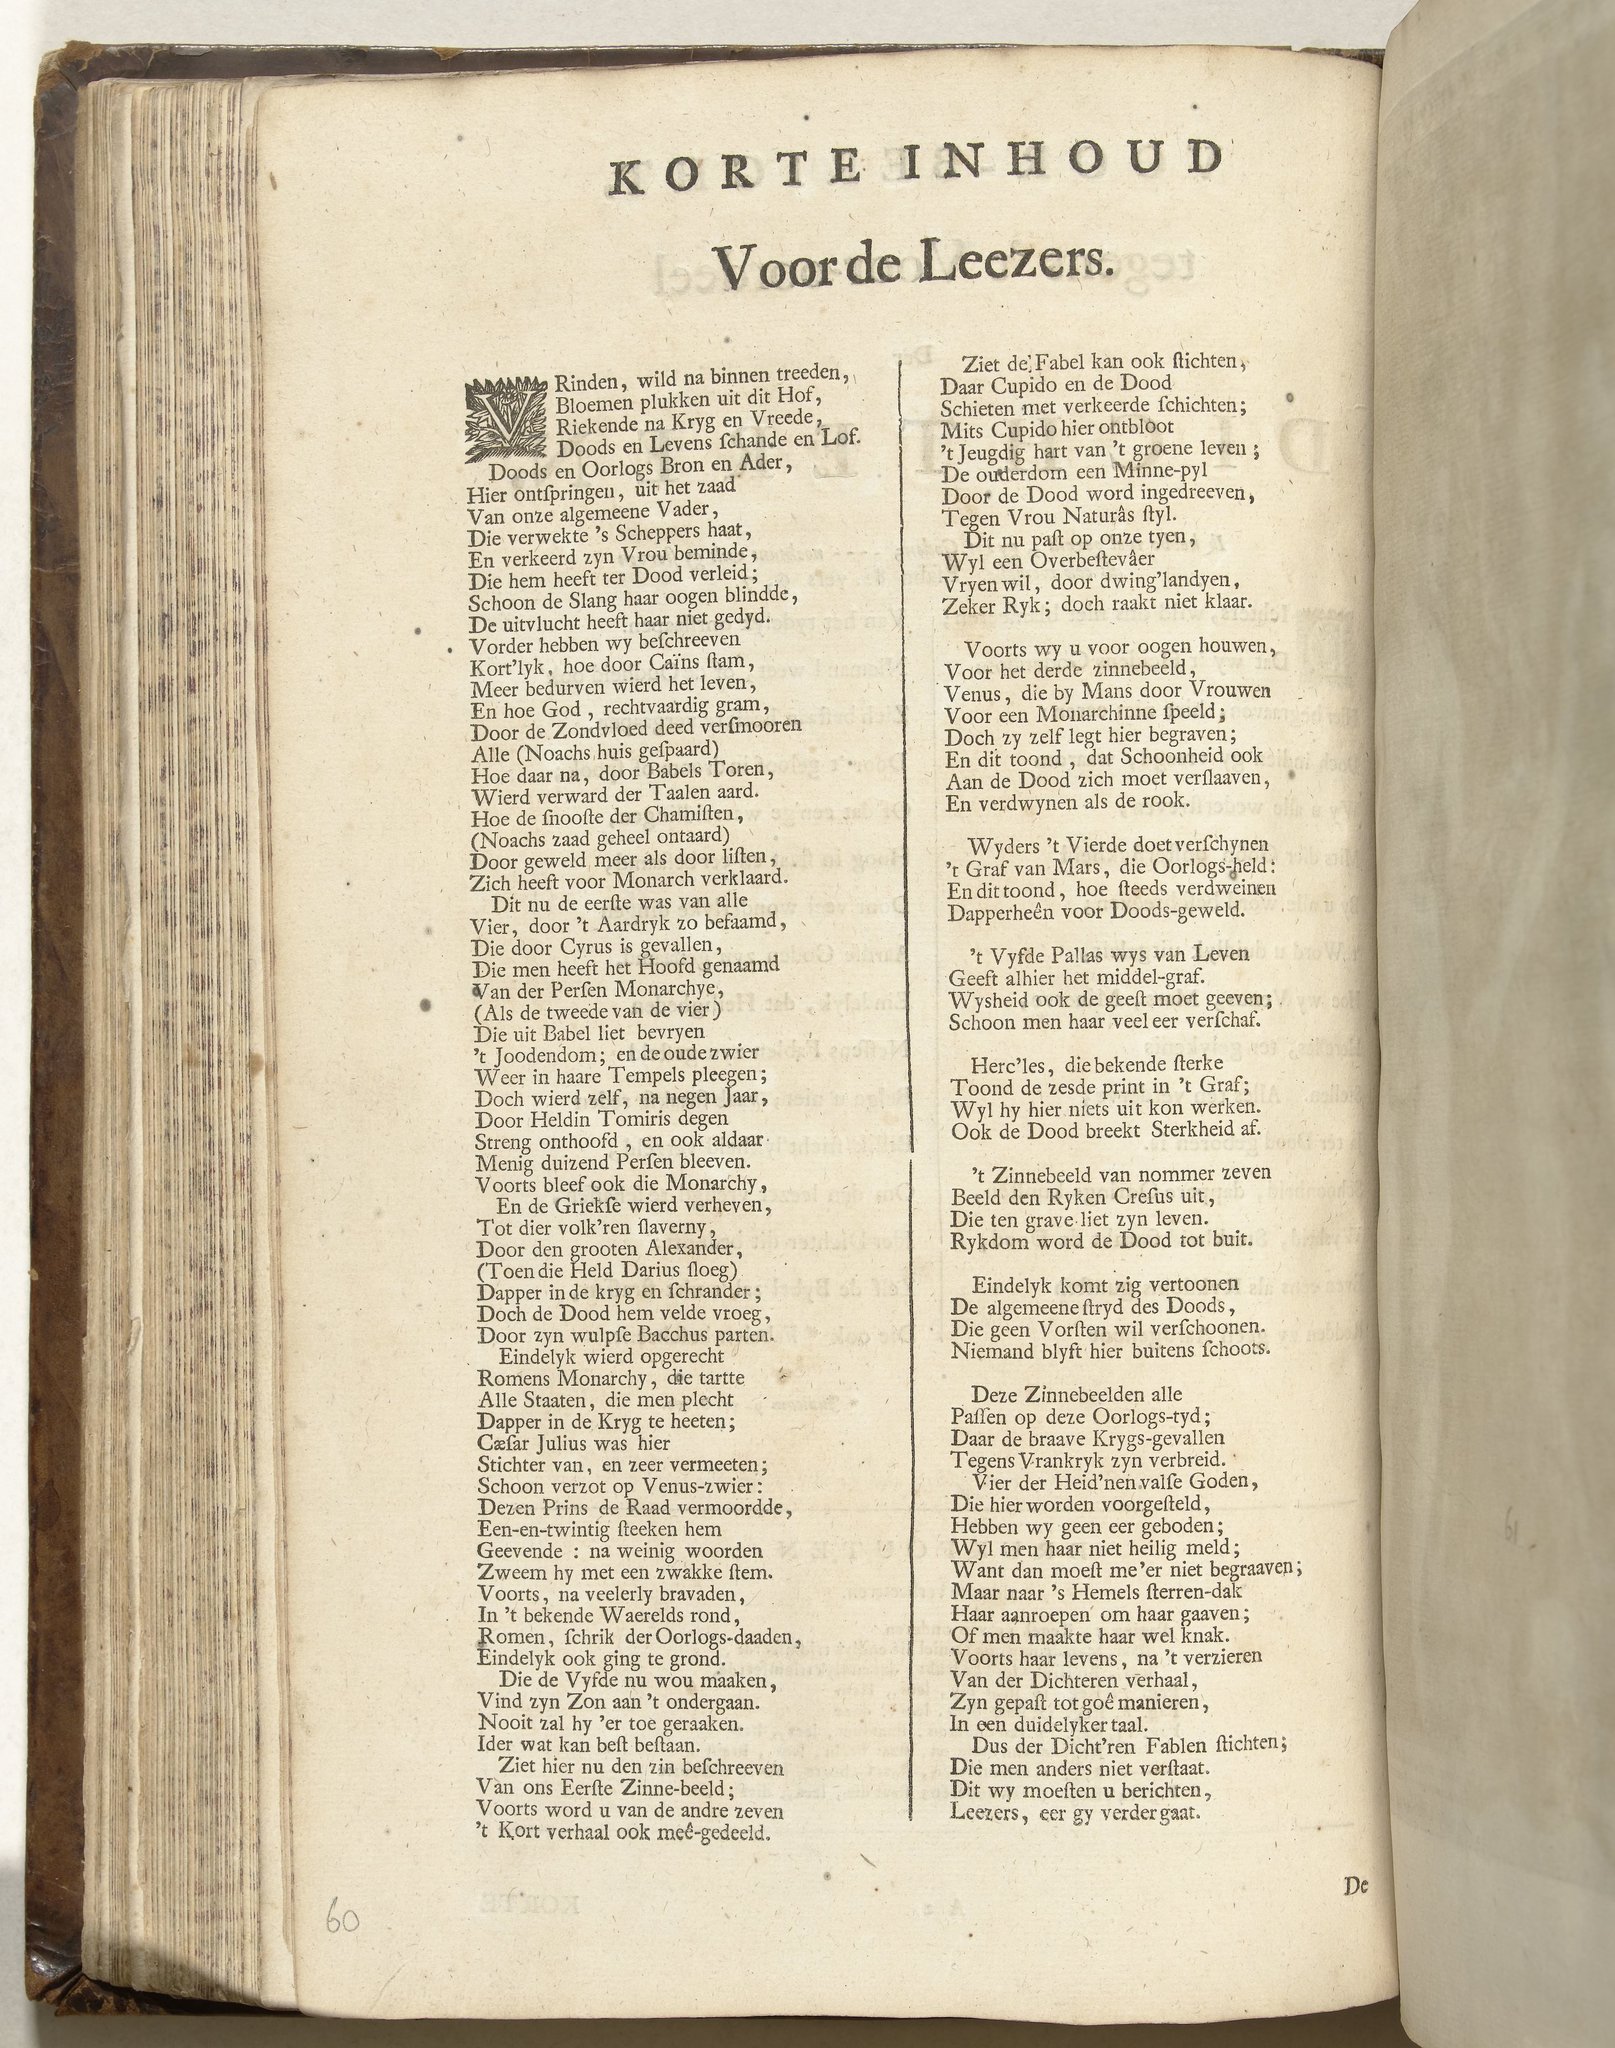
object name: text sheet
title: Korte Inhoud Voor de Leezers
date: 1707-1708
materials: paper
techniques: letterpress printing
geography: amsterdam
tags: spaanse successieoorlog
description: Inhoudsopgave in versvorm in: De Standvastige Monarchye des Doods, ca. 1707-1708, een reeks van 8 oude platen met verzen aangepast voor gebruik als spotprenten op de Fransen in de context van de Spaanse Successieoorlog. Onderdeel van het prentwerk uitgegeven onder de verzameltitel 't Lust-Hof van Momus met de gebundelde series van spotprenten tijdens de jaren 1701-1713 van de Spaanse Successieoorlog.